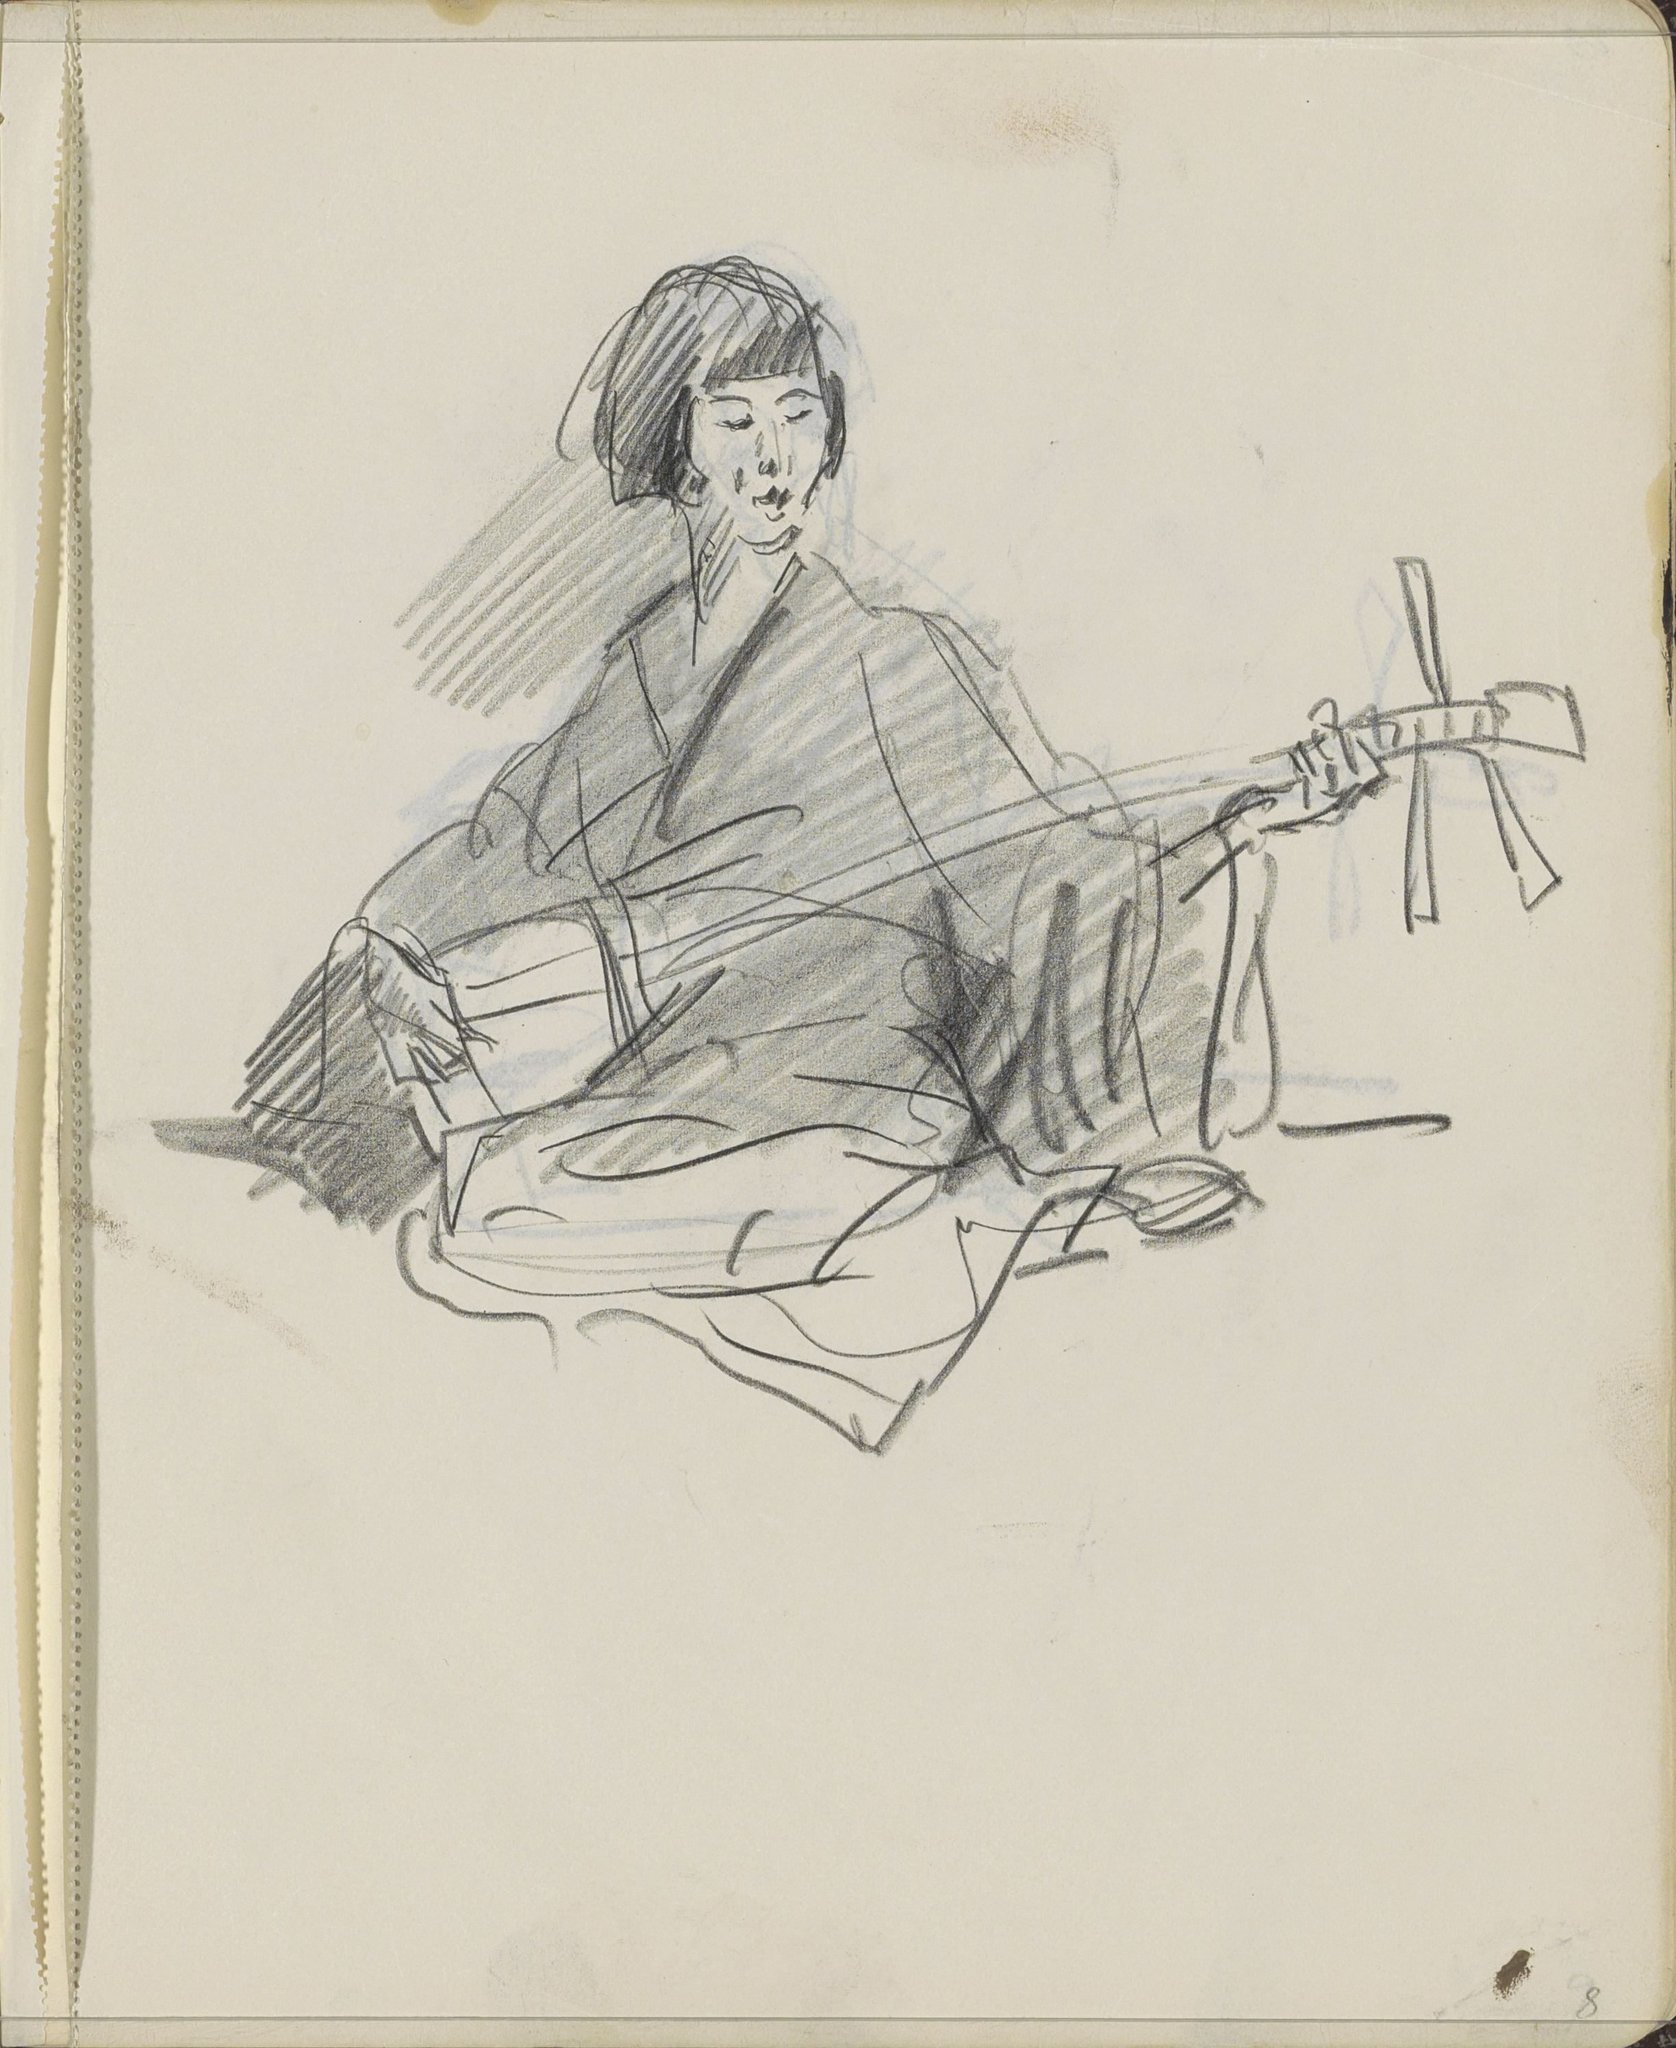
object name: sketchbook leaf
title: Zittende Japanse vrouw met shamisen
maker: isaac israels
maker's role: draughtsman, painter, print maker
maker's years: 1865-1934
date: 1925-1934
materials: paper, pencil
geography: the hague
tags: string instruments (plucked), adult woman (+ sitting), japanese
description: Een shamisen is een Japans snaarinstrument. Blad 8 recto uit schetsboek XXVI met 35 bladen.